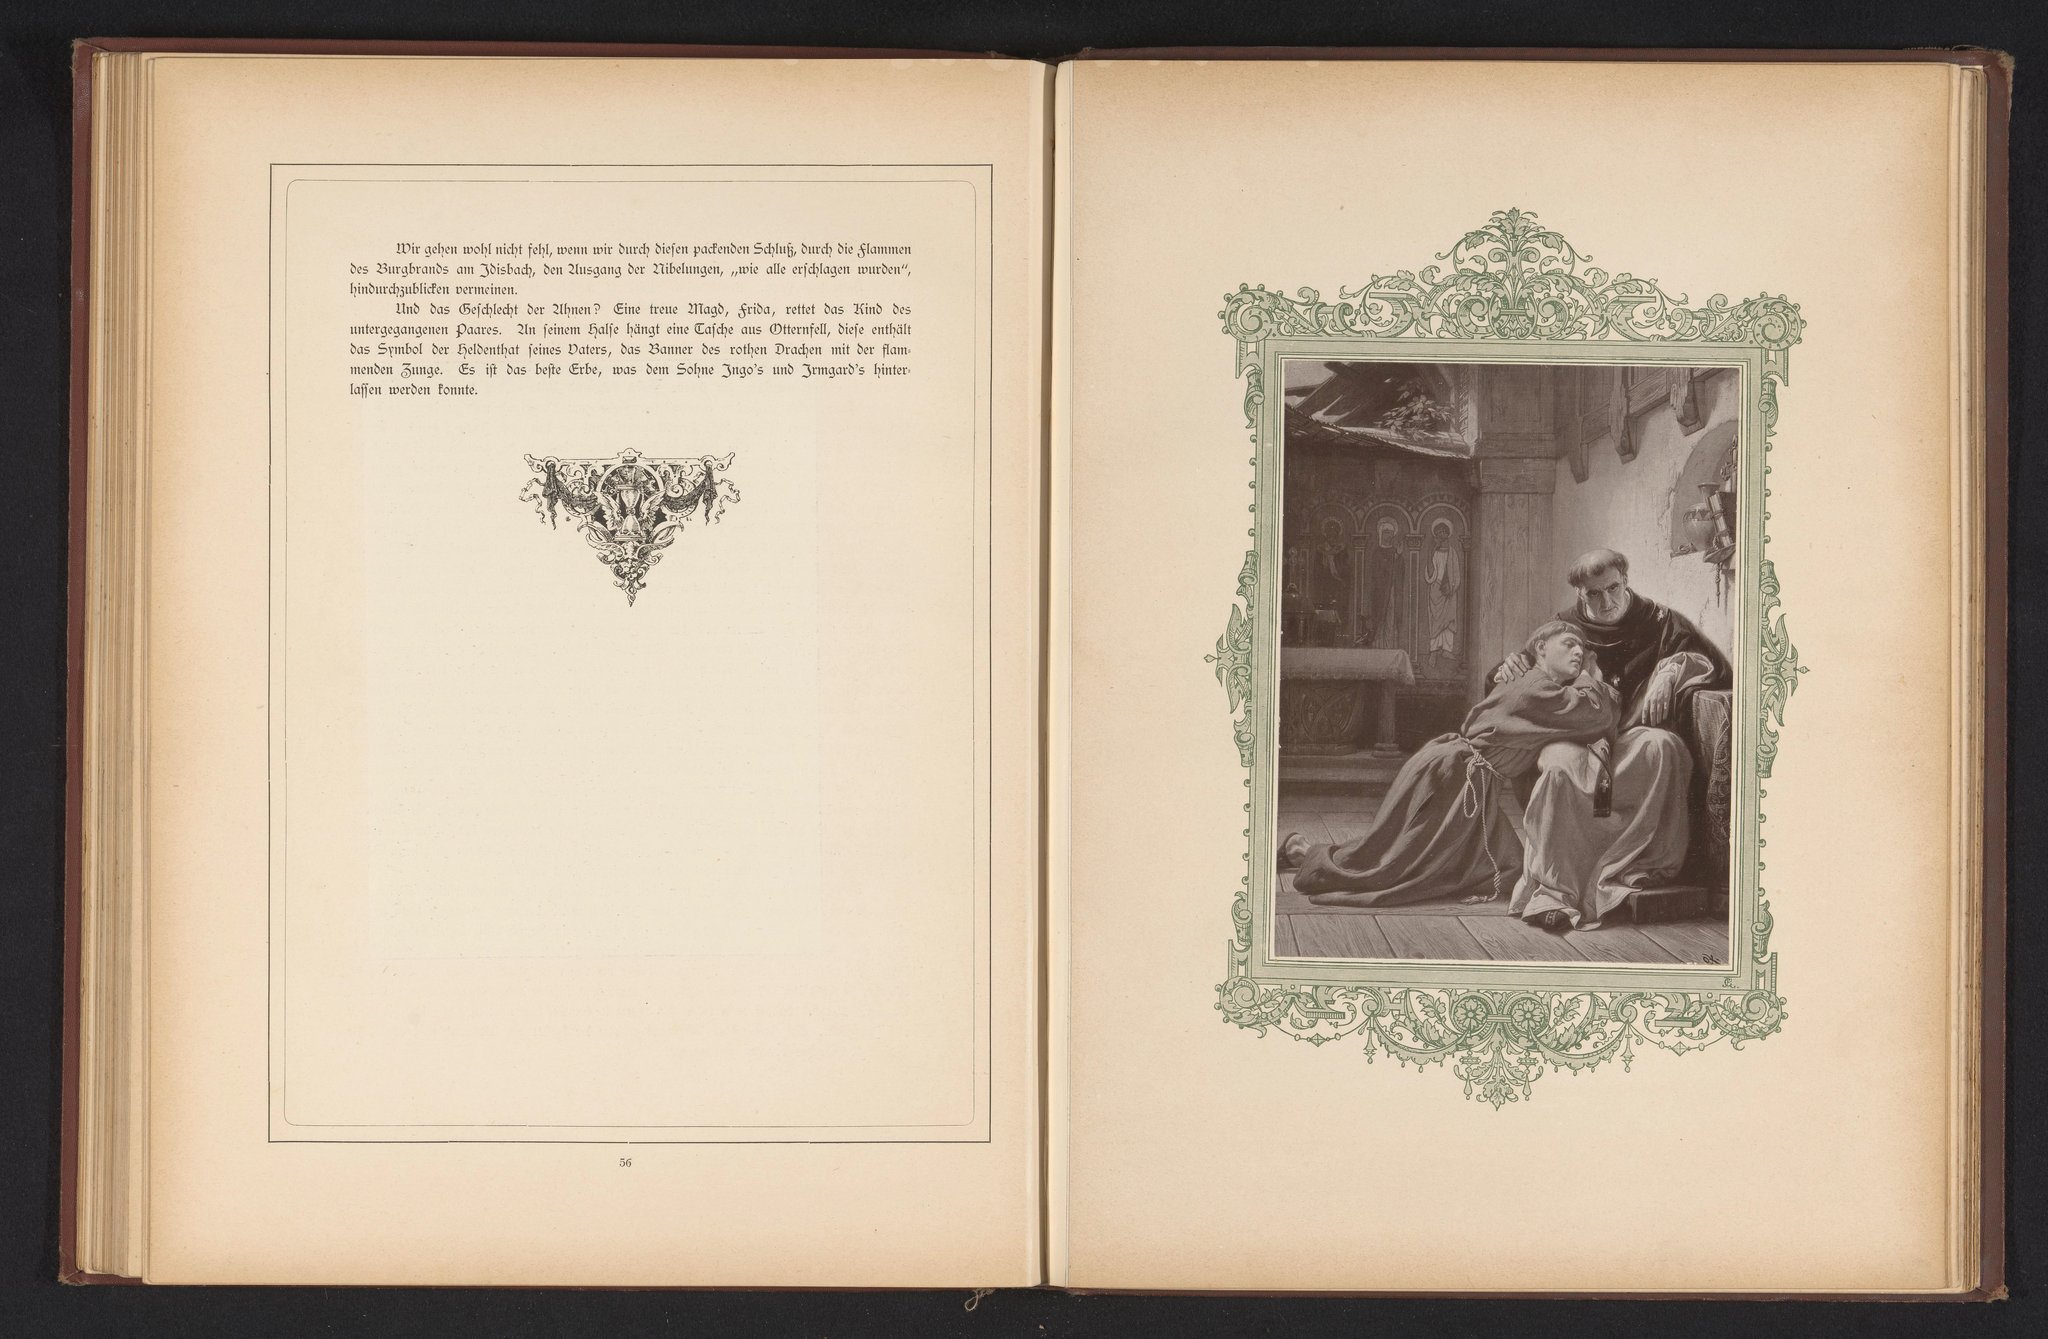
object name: reproduction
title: Fotoreproductie van een schilderij voorstellende een scene met Gottfried bij een bisschop uit Die Ahnen door Gustav Freytag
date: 1877-1882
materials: paper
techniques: photograph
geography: germany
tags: archbishop, bishop, etc. (roman catholic)